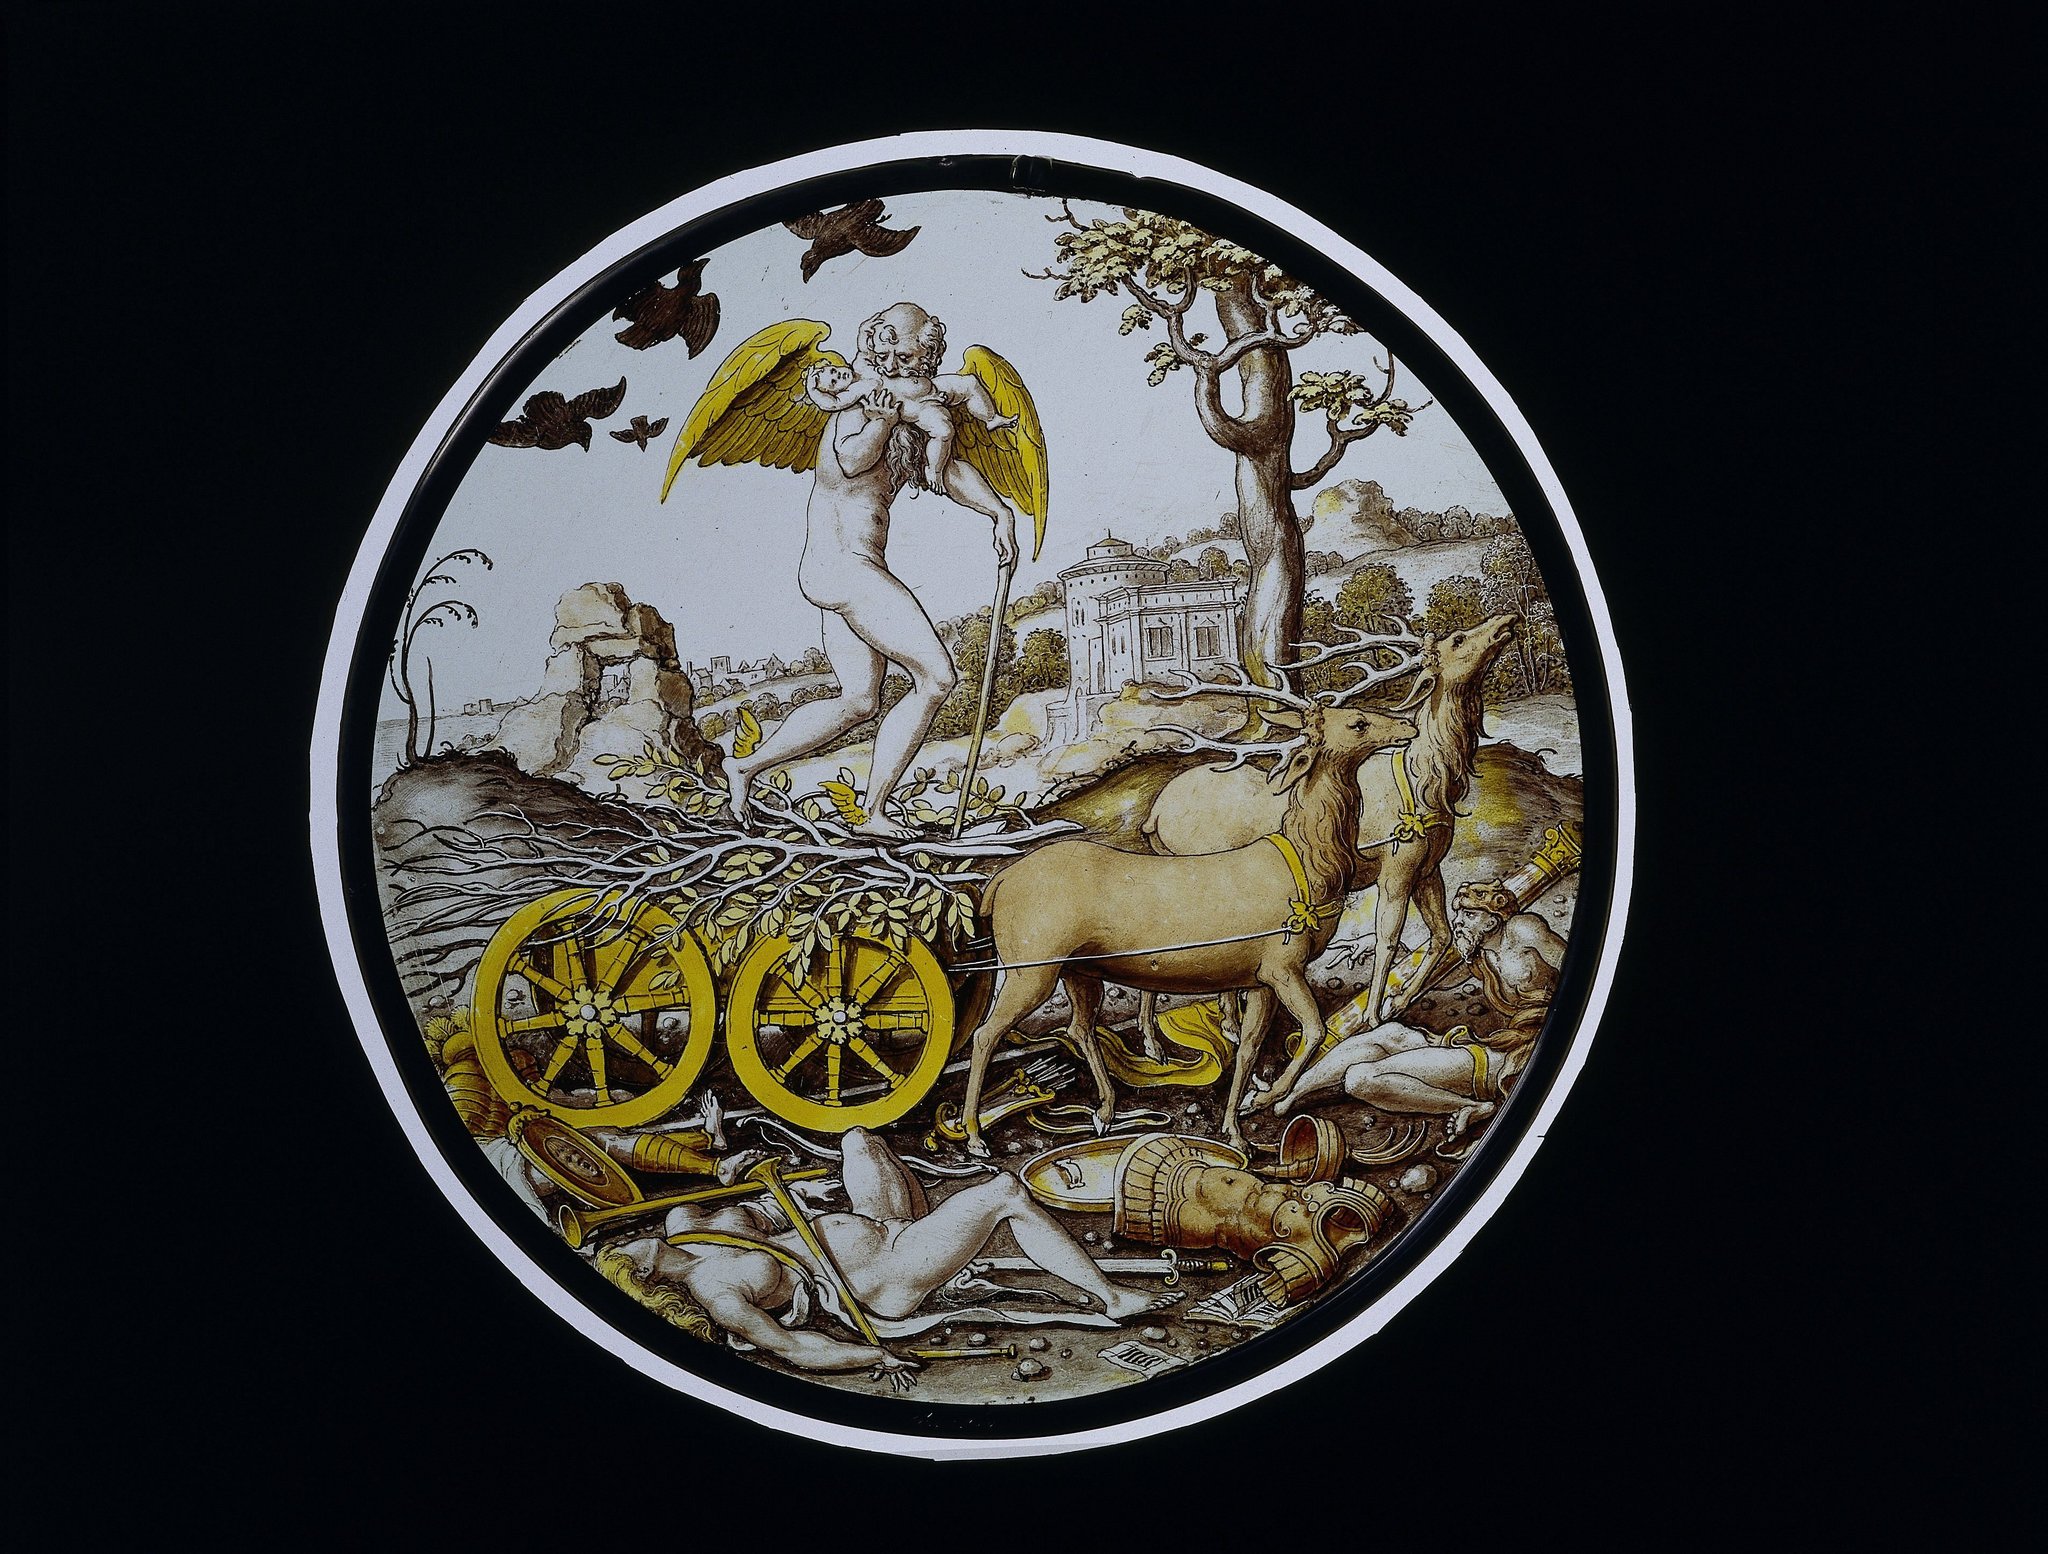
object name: light window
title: The Triumph of Time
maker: Anonymous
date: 1530-1540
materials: glass, lead, pigment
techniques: leading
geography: southern netherlands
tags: fame; 'fama', 'fama buona', 'fama chiara' (ripa) (+ variant), saturn devouring his children, 'trionfo del tempo', 'triumphus temporis'; 'carro del tempo' (ripa), triumph of saturn; 'carro di saturno' (ripa), hercules as personification of some other abstract notion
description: Ruit met gebrandschilderde voorstelling van De Triomf van de Tijd, voorgesteld door Kronos staande op een door twee herten getrokken zegewagen die bedekt is met ten dele ontbladerde takken. Op de voorgrond krijgstrofeeën en de overwonnen figuur van "De Faam" met twee bazuinen. Voor de wagen de figuur van Hercules met een zuil als symbool van "De Kracht". Op de achtergrond een bergachtig landschap met bomen, rotspoort, een klassiek bouwwerk en in het verschiet een stadsgezicht. Kleuren: geel, bruin, groen en grisaille.